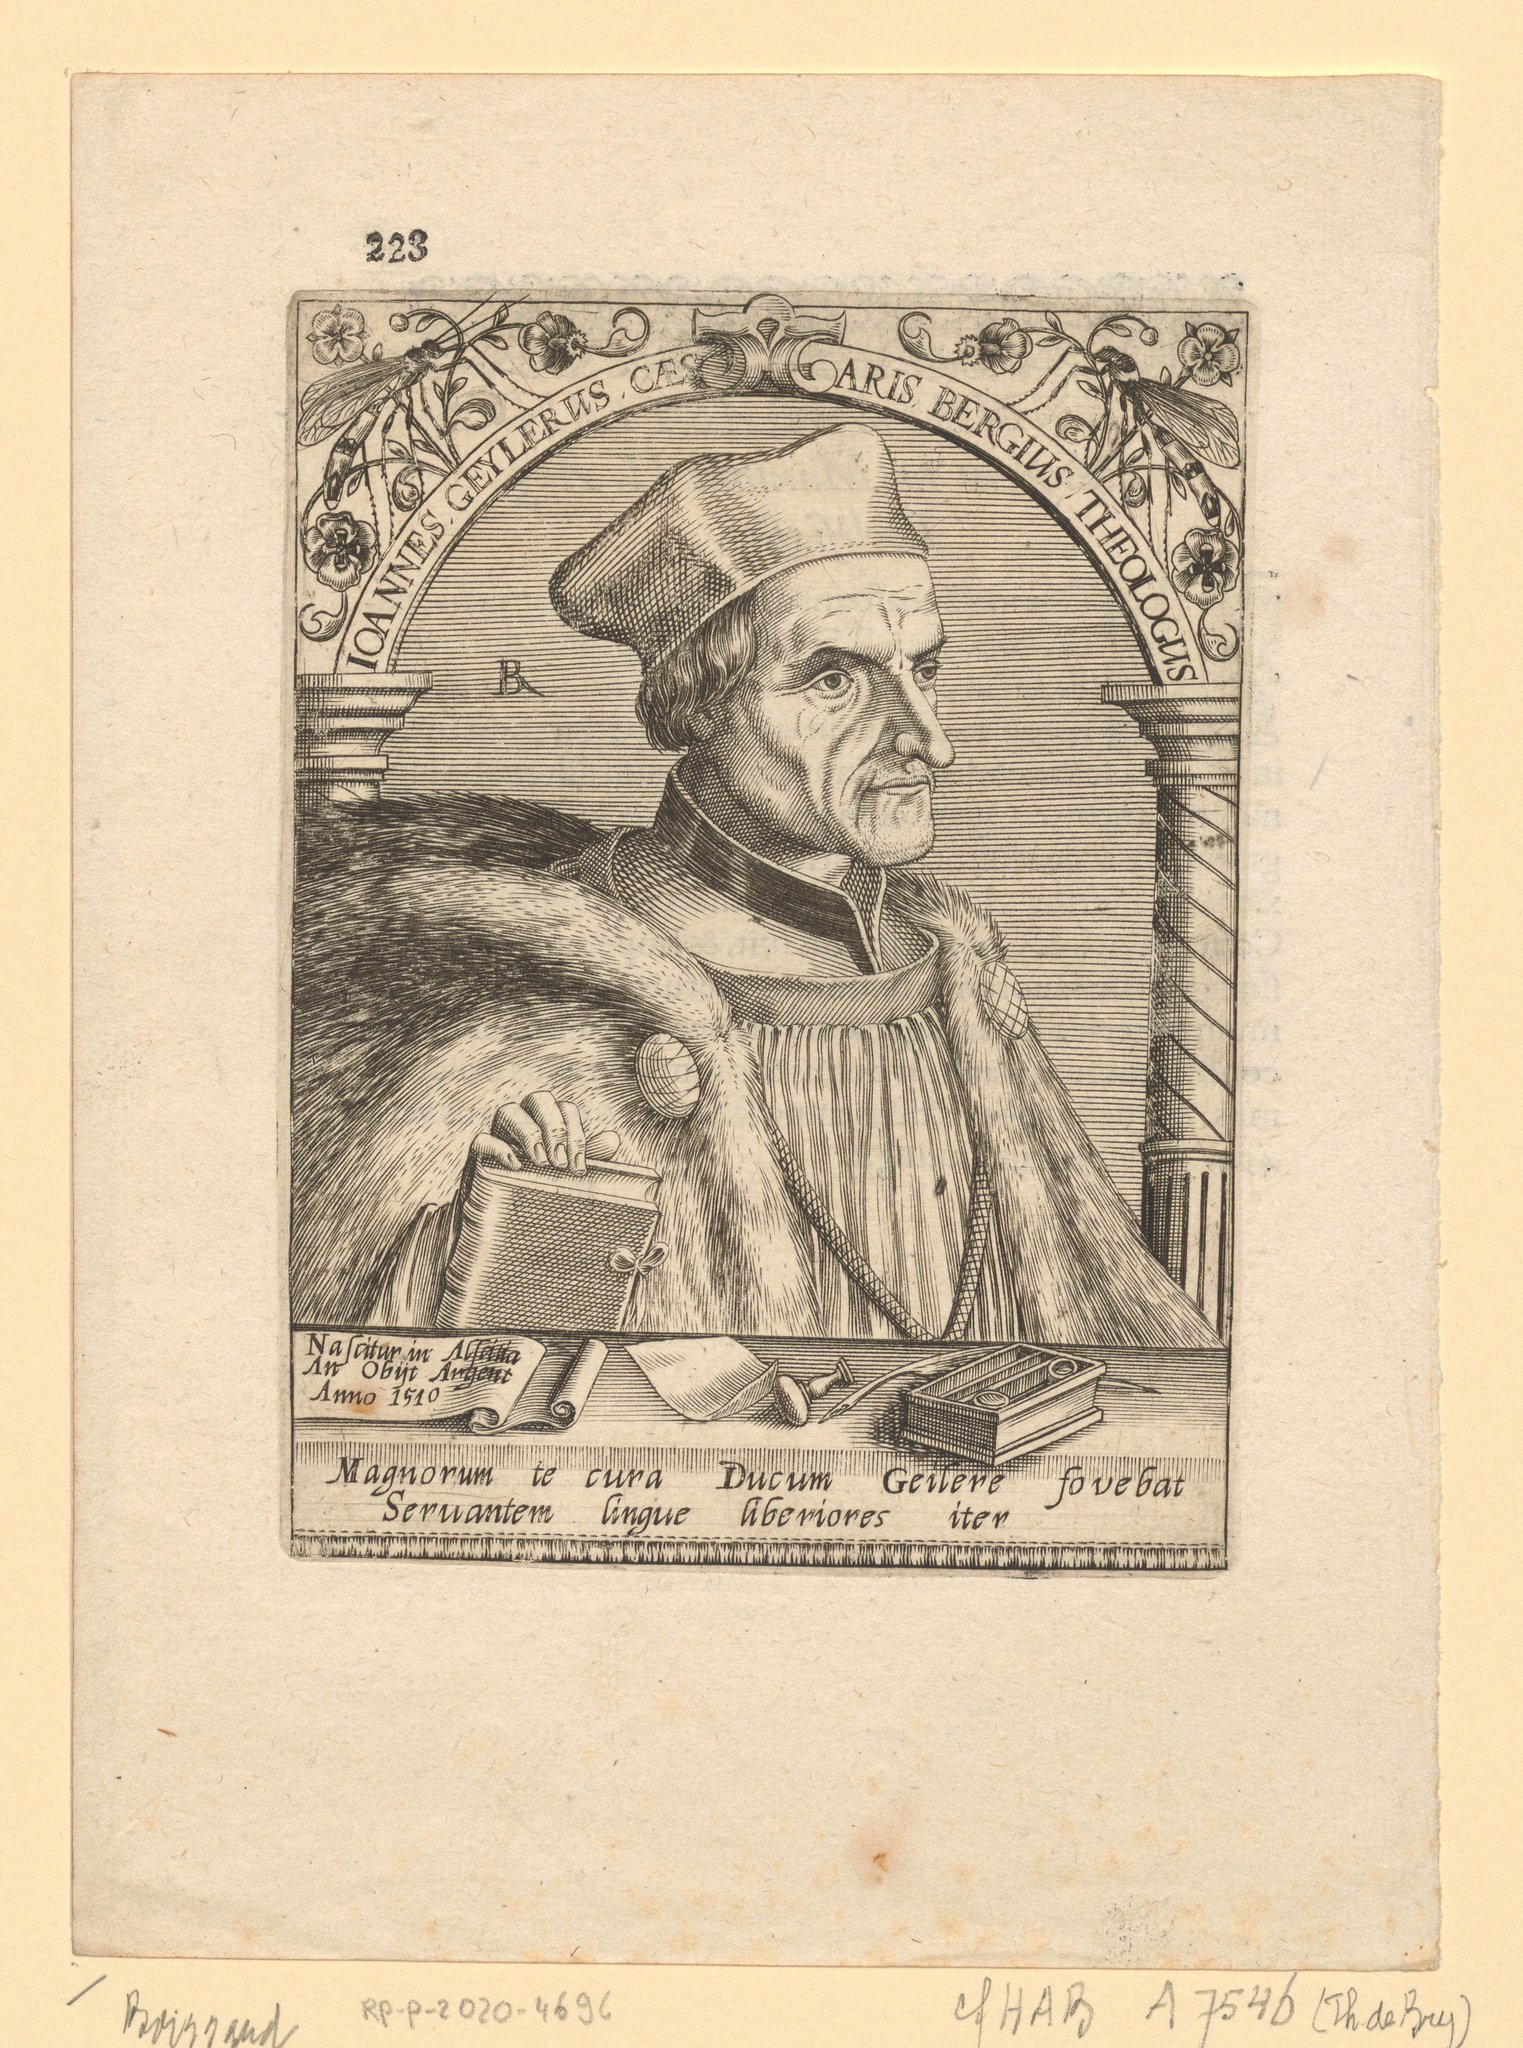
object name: print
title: Portret van Johann Geiler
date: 1606-1666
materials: paper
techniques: engraving, letterpress printing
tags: theologian, historical persons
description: Prent mogelijk uit: Boissard, Jean-Jacques en Theodoor de Bry. Bibliotheca sive thesaurus virtutis et gloriae in quo continentur illustrium eruditione et doctrina virorum effigies et vitae (...). Frankfurt: William Fitzer, 1628.